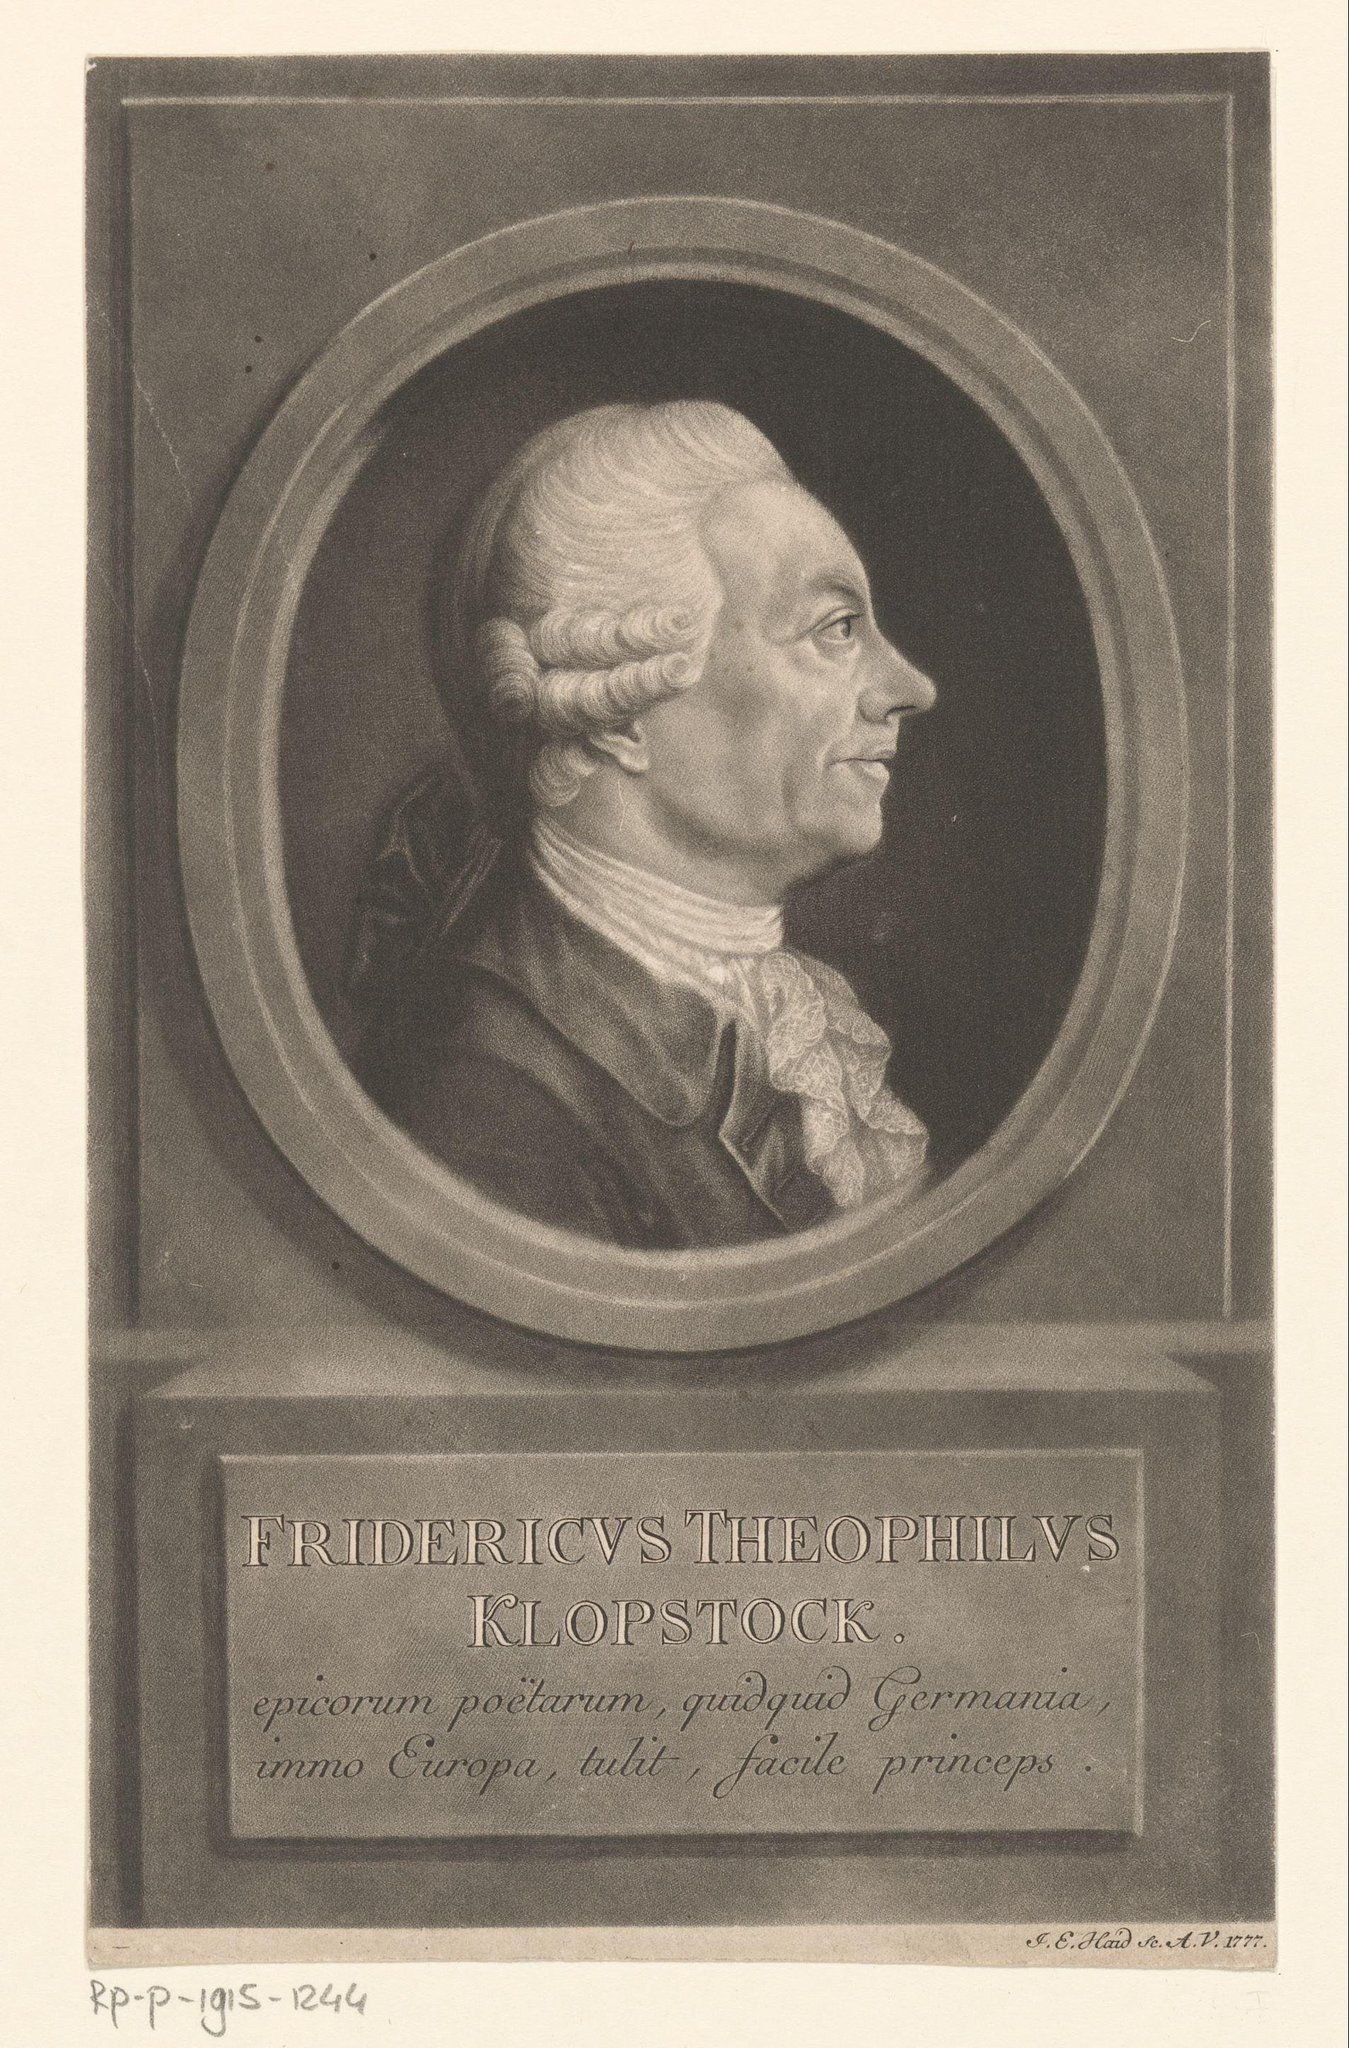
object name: print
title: Portret van Friedrich Gottlieb Klopstock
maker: johann elias haid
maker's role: print maker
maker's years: 1739-1809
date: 1777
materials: paper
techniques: mezzotint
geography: augsburg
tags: historical persons, writer, poet, author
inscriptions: collector's mark: Lugt 2228